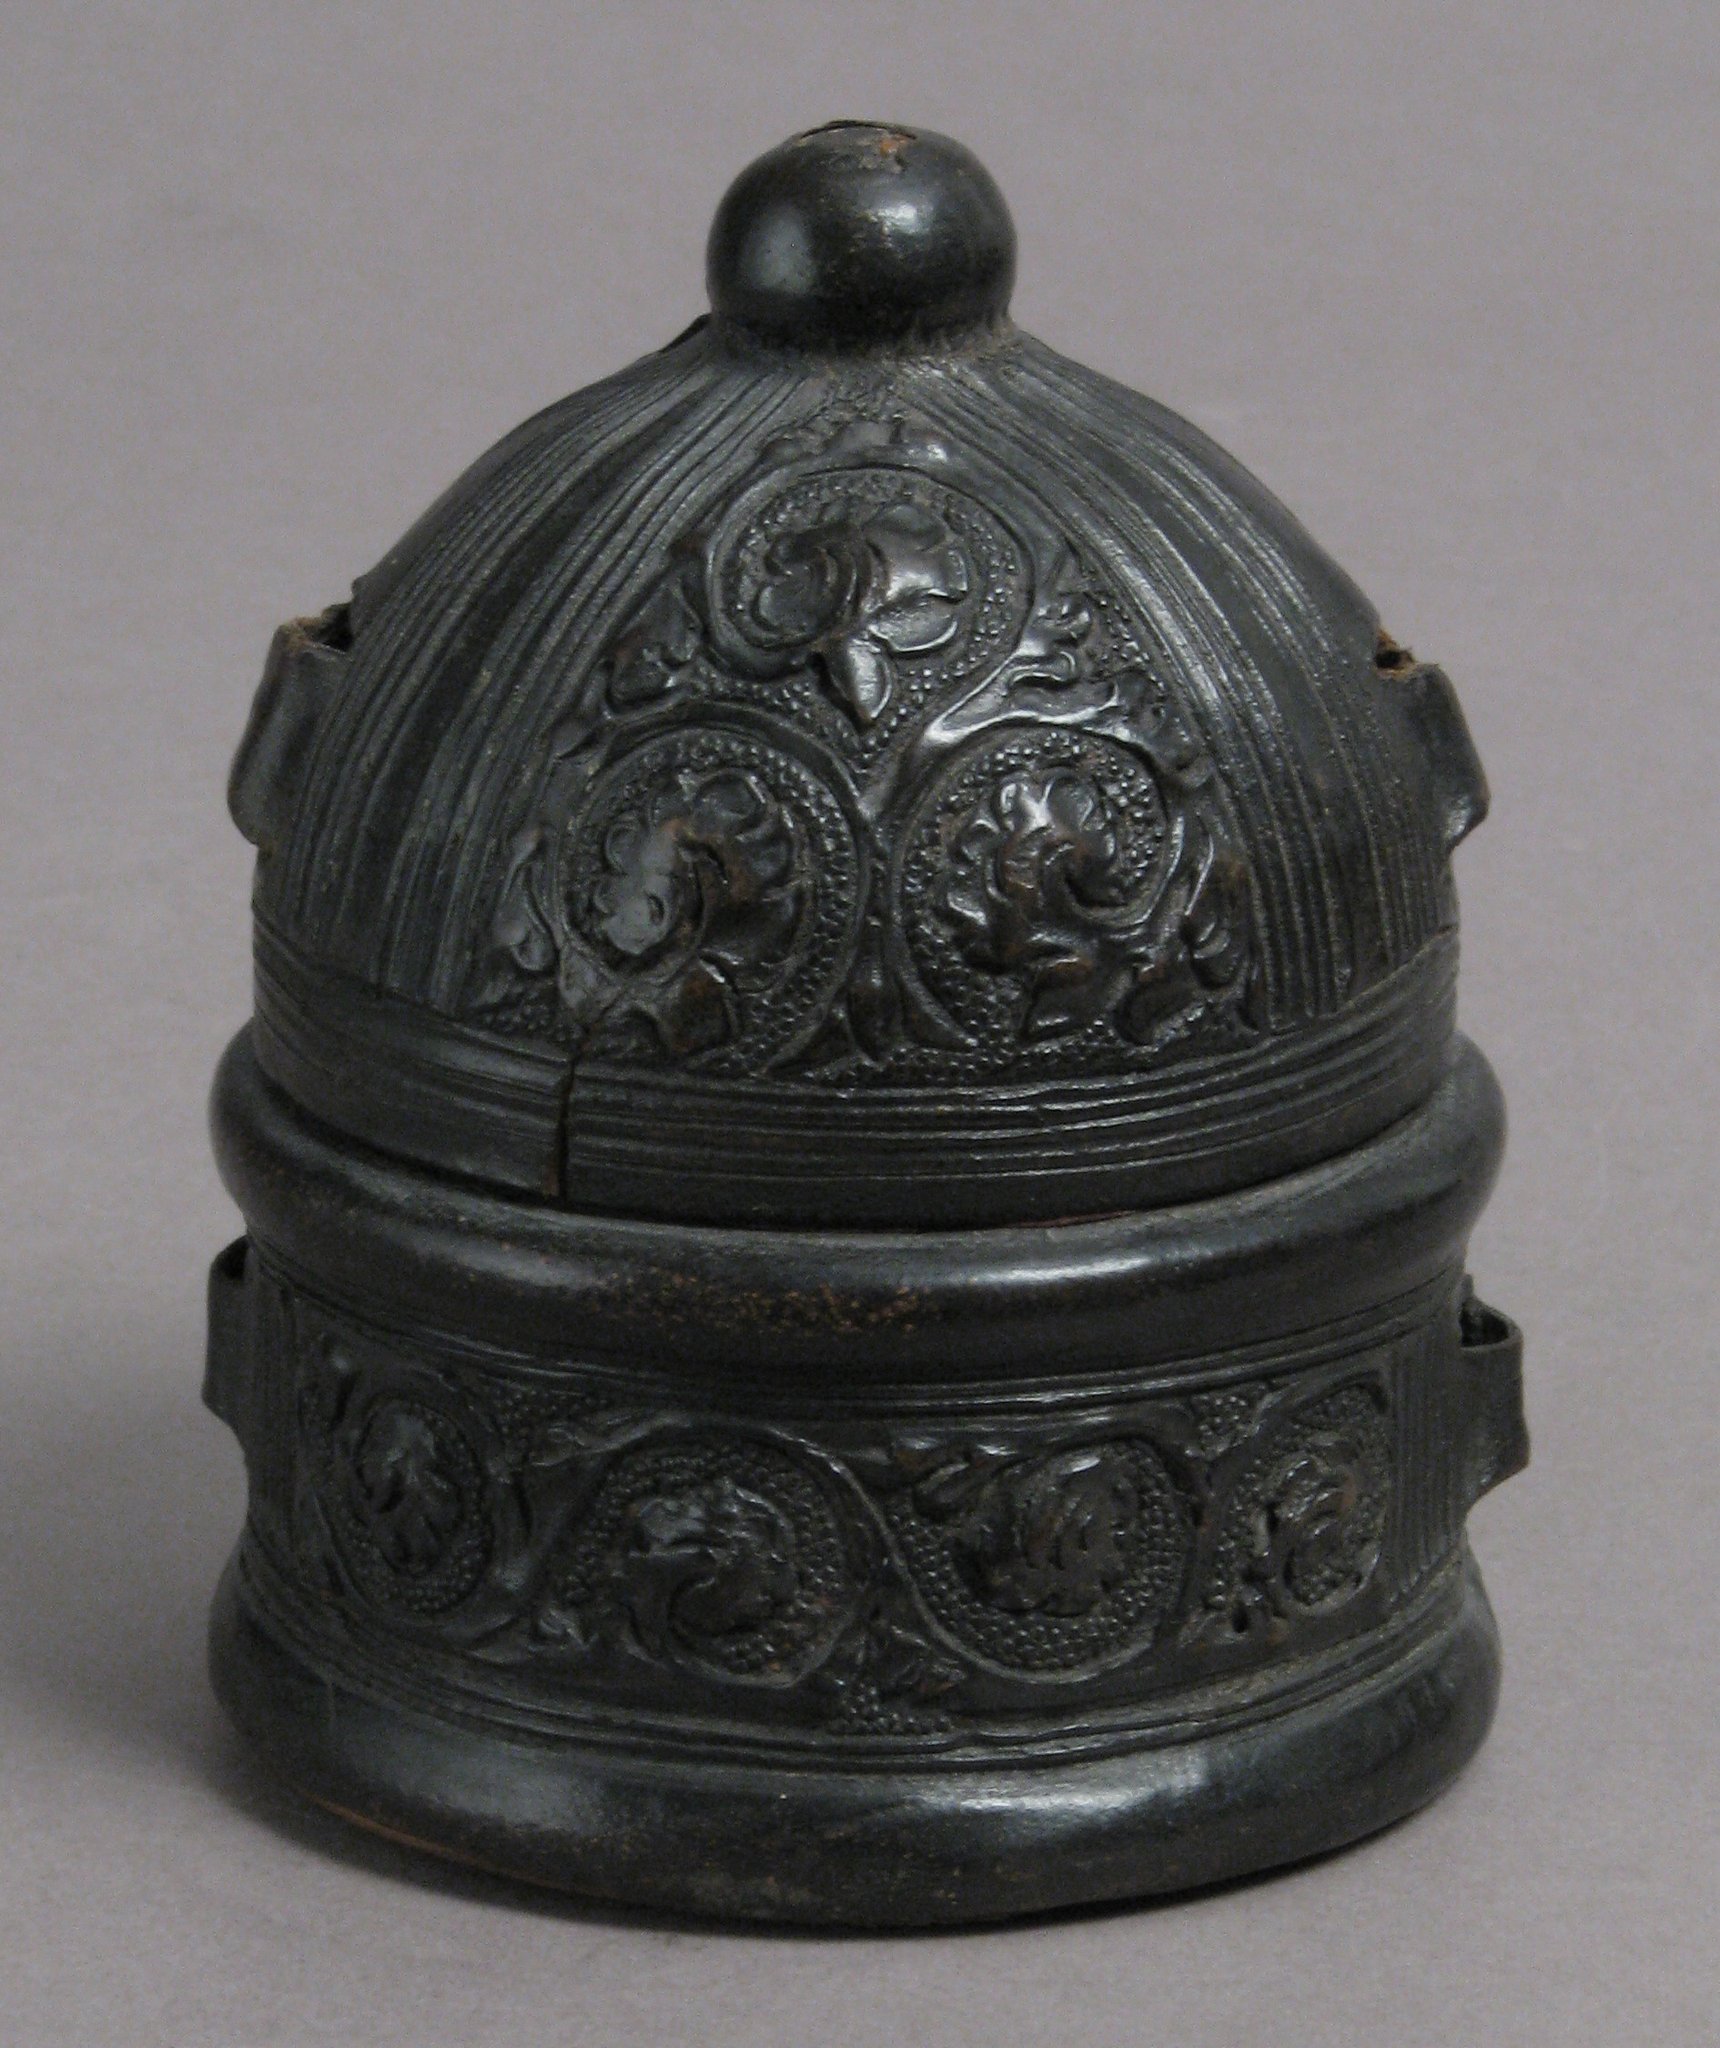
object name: box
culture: italian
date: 1401-1500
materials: leather, textile, wood